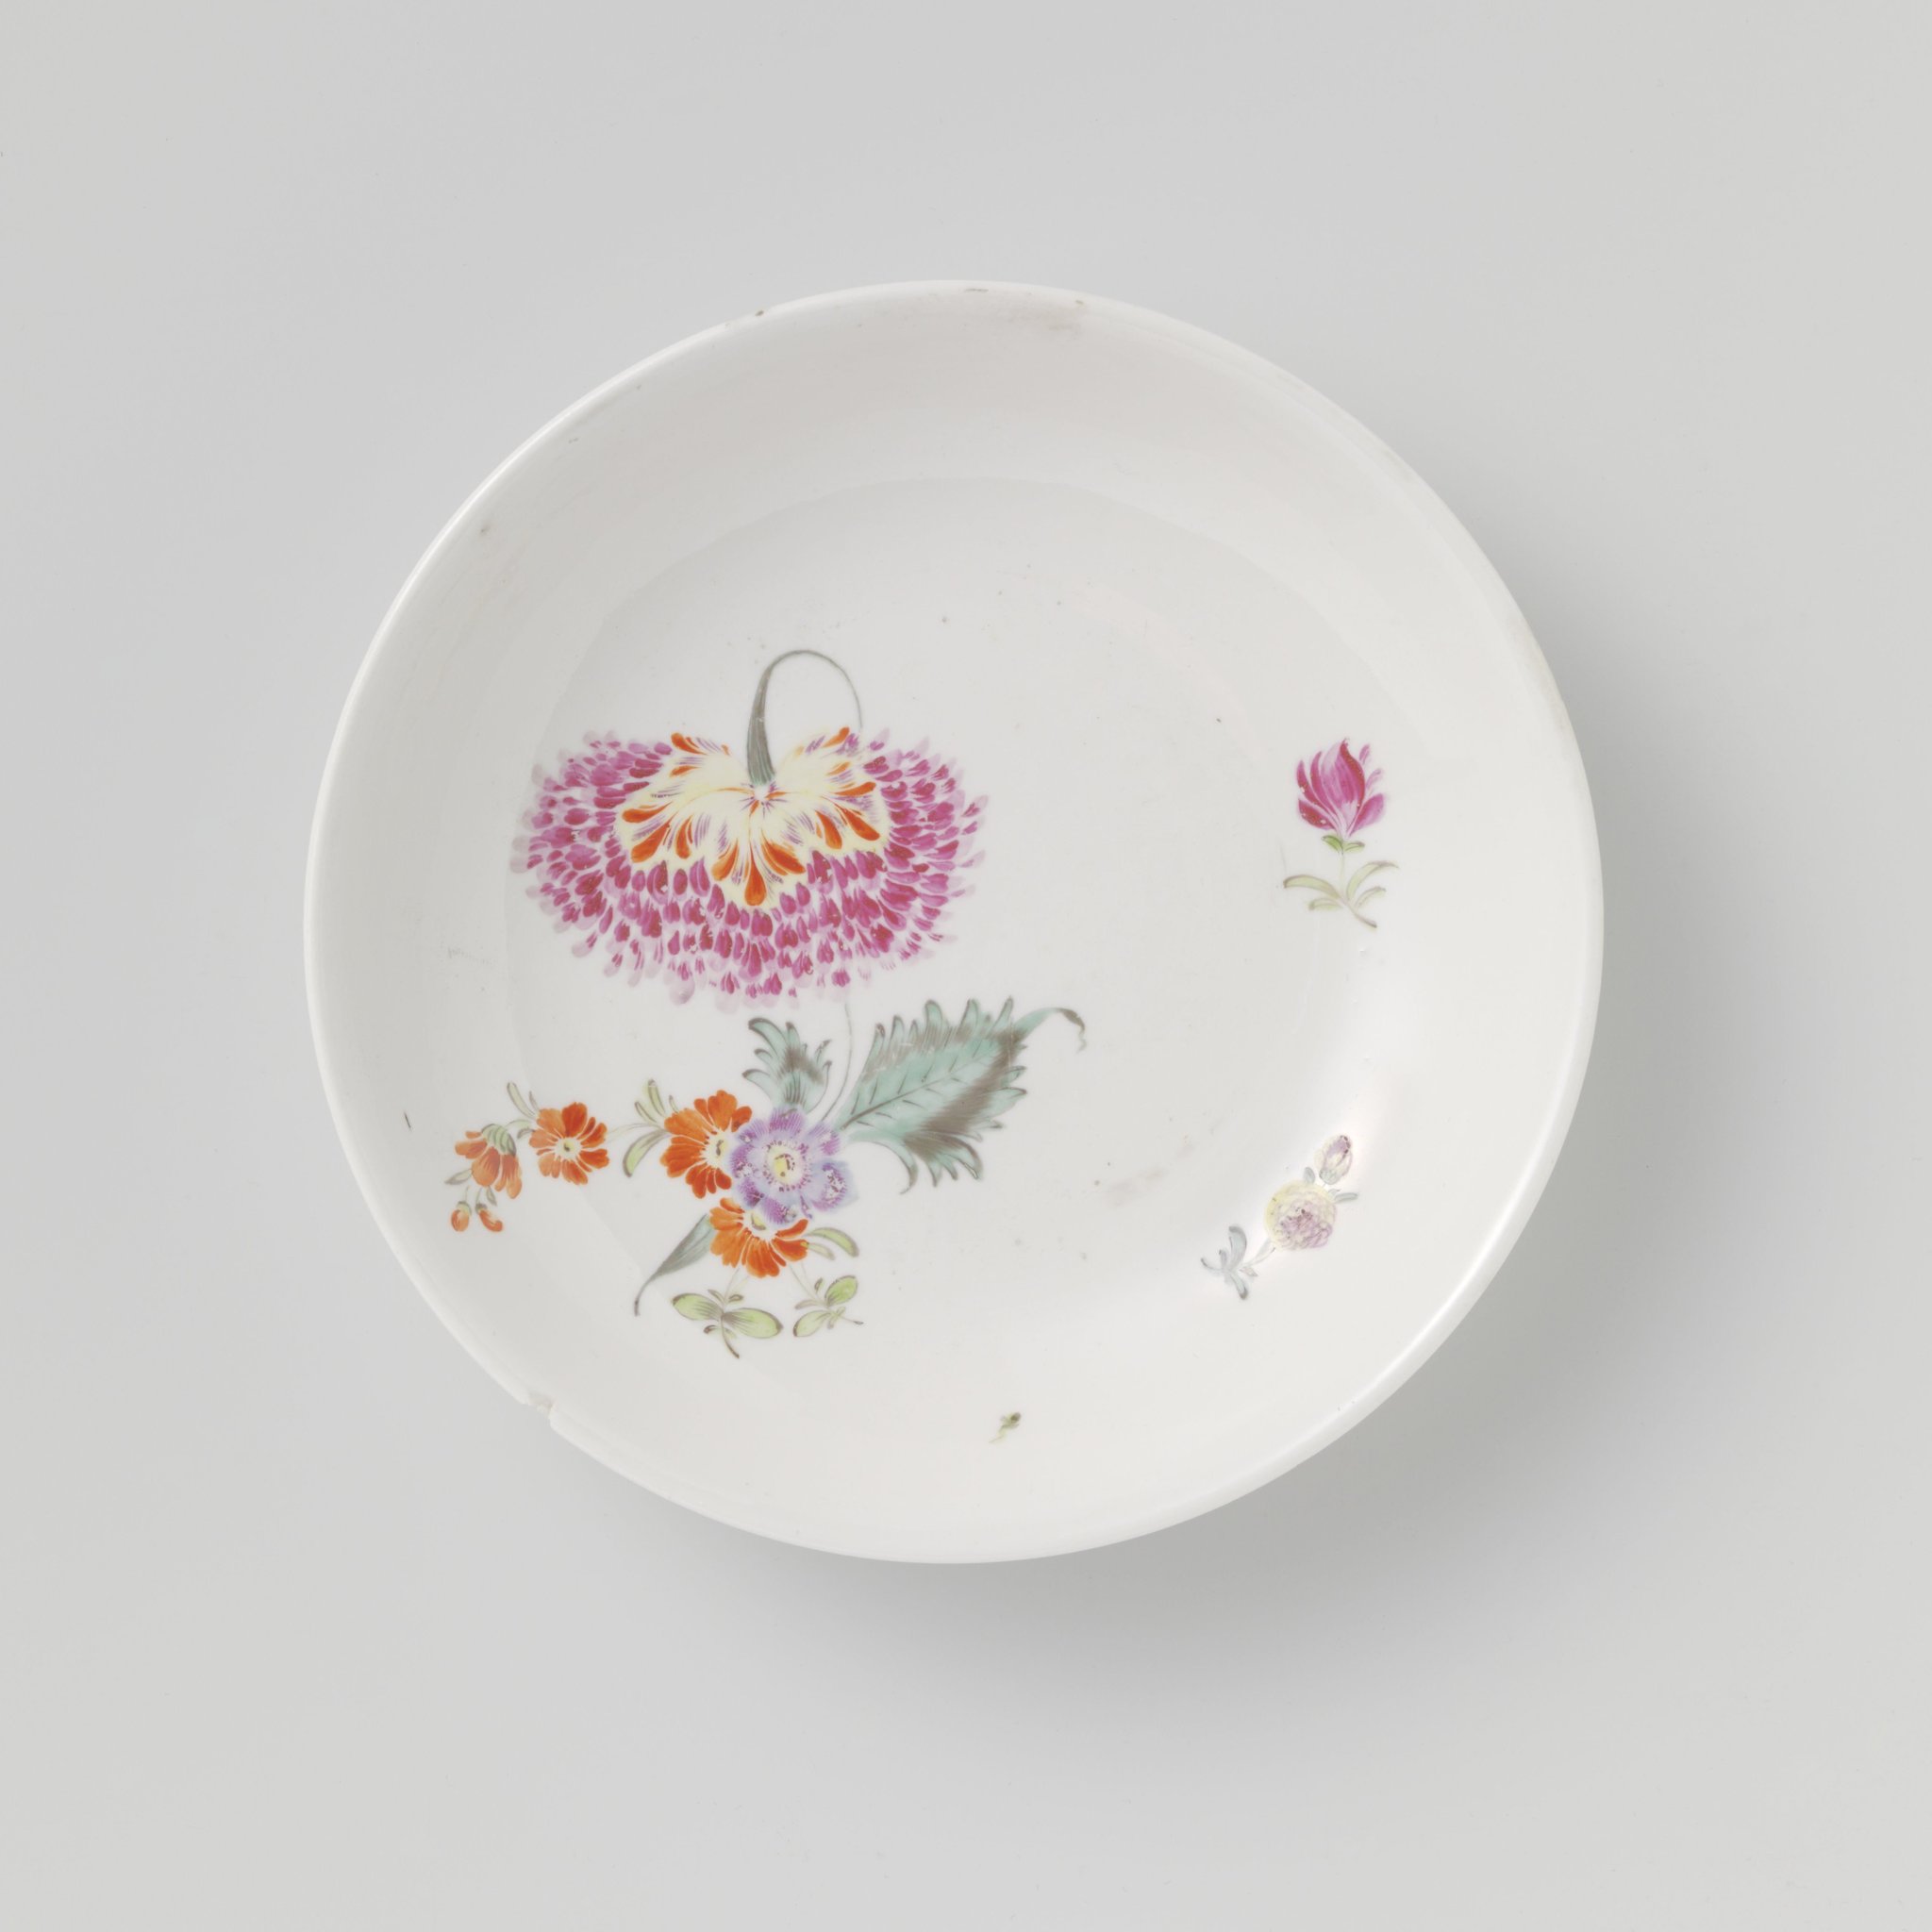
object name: platter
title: Saucer with flower sprays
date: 1760-1800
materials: glaze, paint, porcelain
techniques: firing, turning, vitrification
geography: ansbach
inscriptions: mark: ‘3’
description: Schotel van porselein, beschilderd op het glazuur in rood, roze, groen, geel en paars. Op de voorzijde grote bloemtakken en strooibloemen. Gemerkt op de onderzijde met een 3.